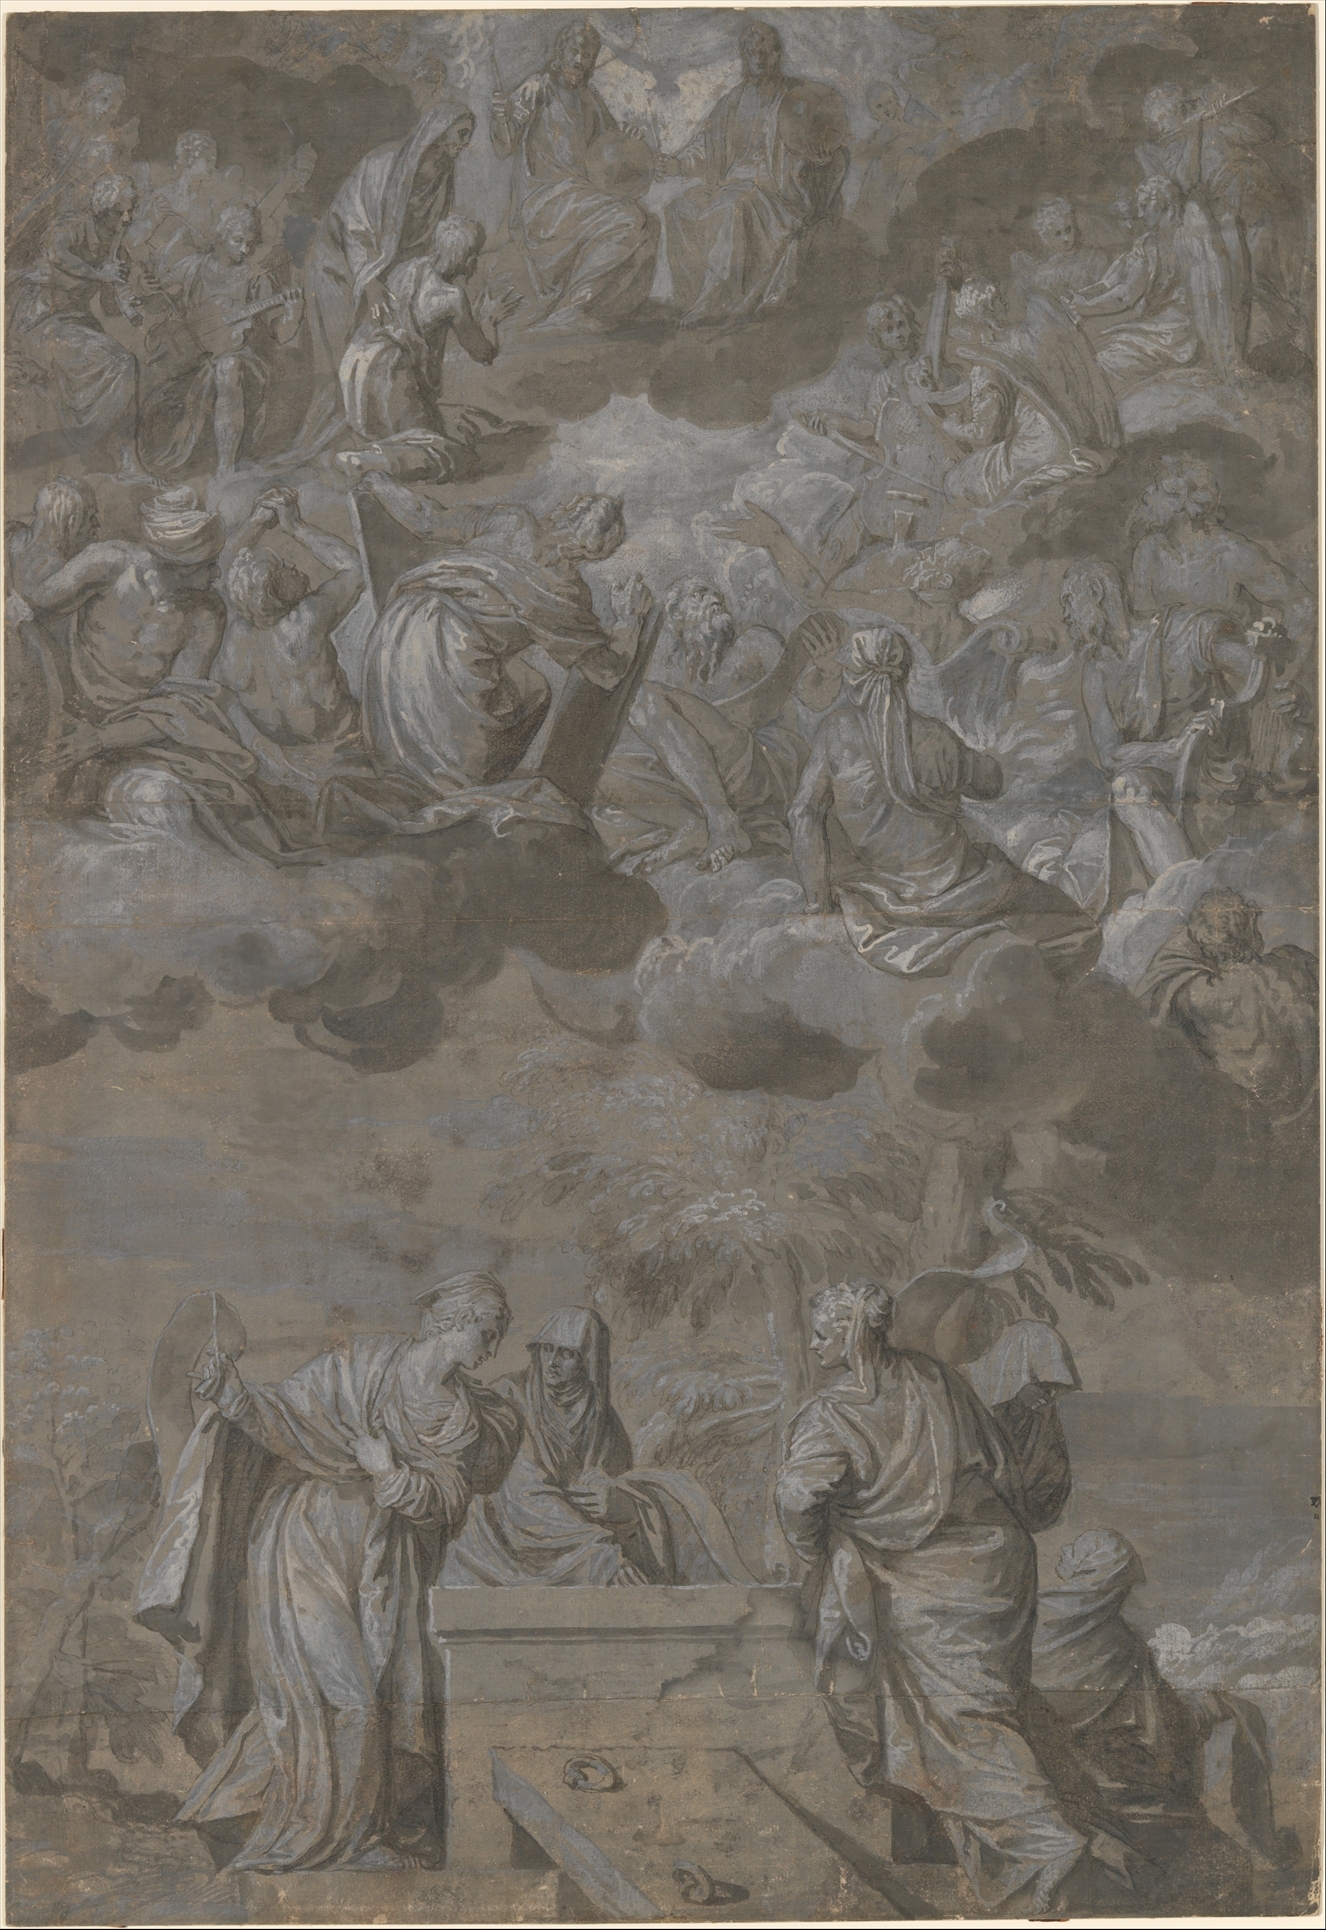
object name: drawing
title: Allegory of the Redemption of the World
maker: paolo veronese (paolo caliari)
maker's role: artist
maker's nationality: italian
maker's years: 1528-1588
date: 1528-1588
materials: gouache, ink, paper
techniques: brush, highlighting, pen, wash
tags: tombs,men,women,allegory